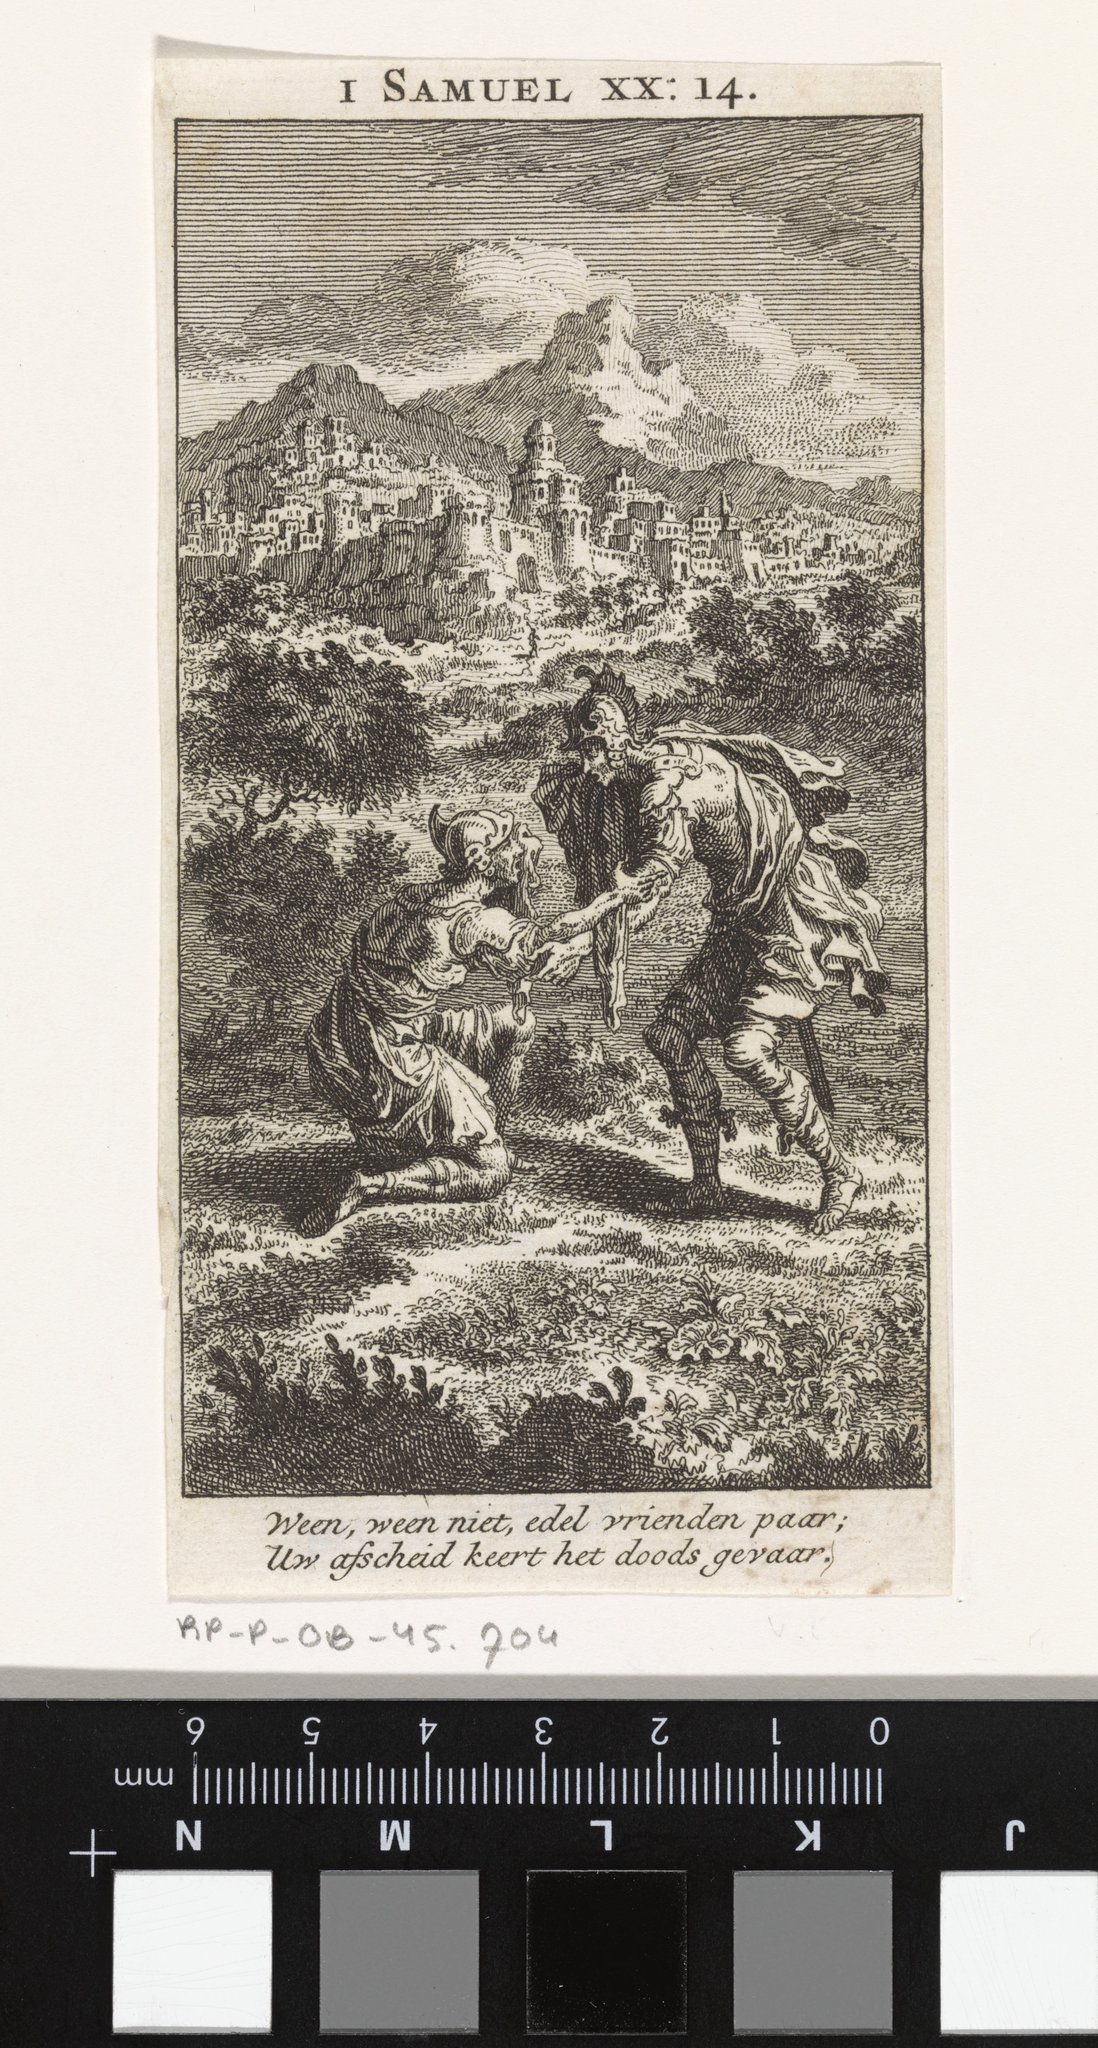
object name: print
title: Afscheid van David en Jonathan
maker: Anonymous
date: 1712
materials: paper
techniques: etching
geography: amsterdam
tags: david and jonathan embracing; david's leave-taking from jonathan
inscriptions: collector's mark: Lugt 240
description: Kopie van illustratie voor: Luyken, Jan. Bybel printen. Amsterdam: Pieter Arentsz. II (wed.) en Cornelis van der Sys, 1712, p. 11.